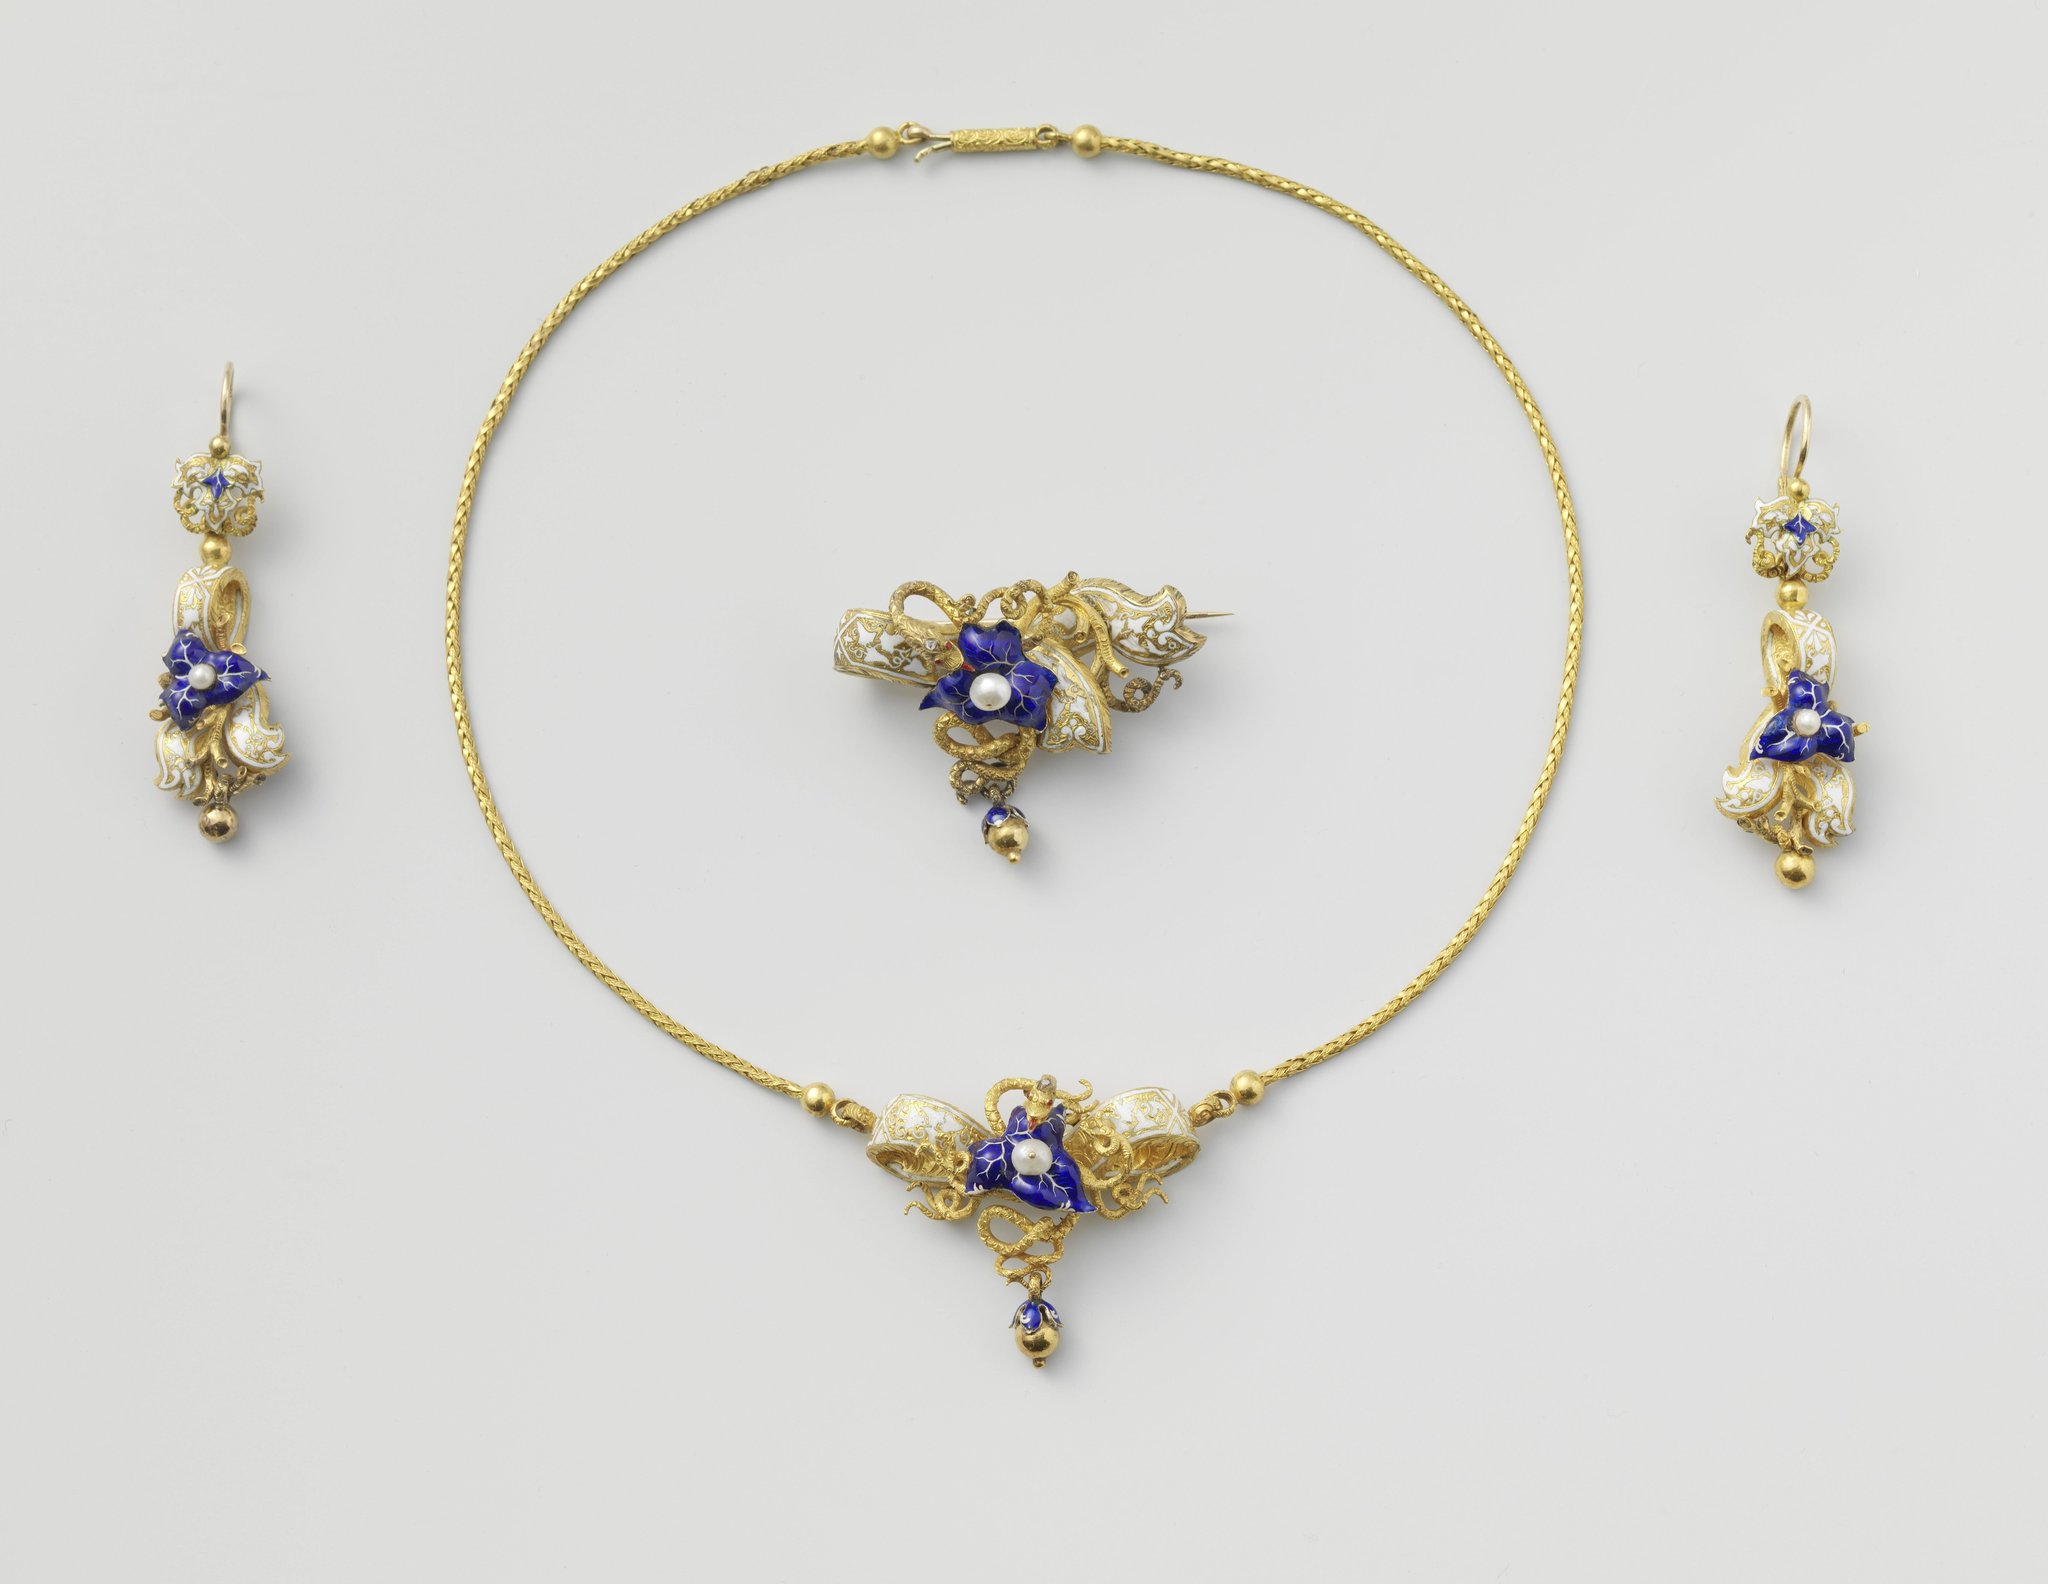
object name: jewellery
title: Demi-parure bestaande uit een collier, een broche en twee oorhangers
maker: Anonymous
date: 1840-1850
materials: diamond, gold, pearl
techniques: enameling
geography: germany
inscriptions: mark: ‘IL (?) in rechthoek’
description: Parure. Gold, diamonds, pearls and enamel. Germany (?), c. 1840 - 1850.